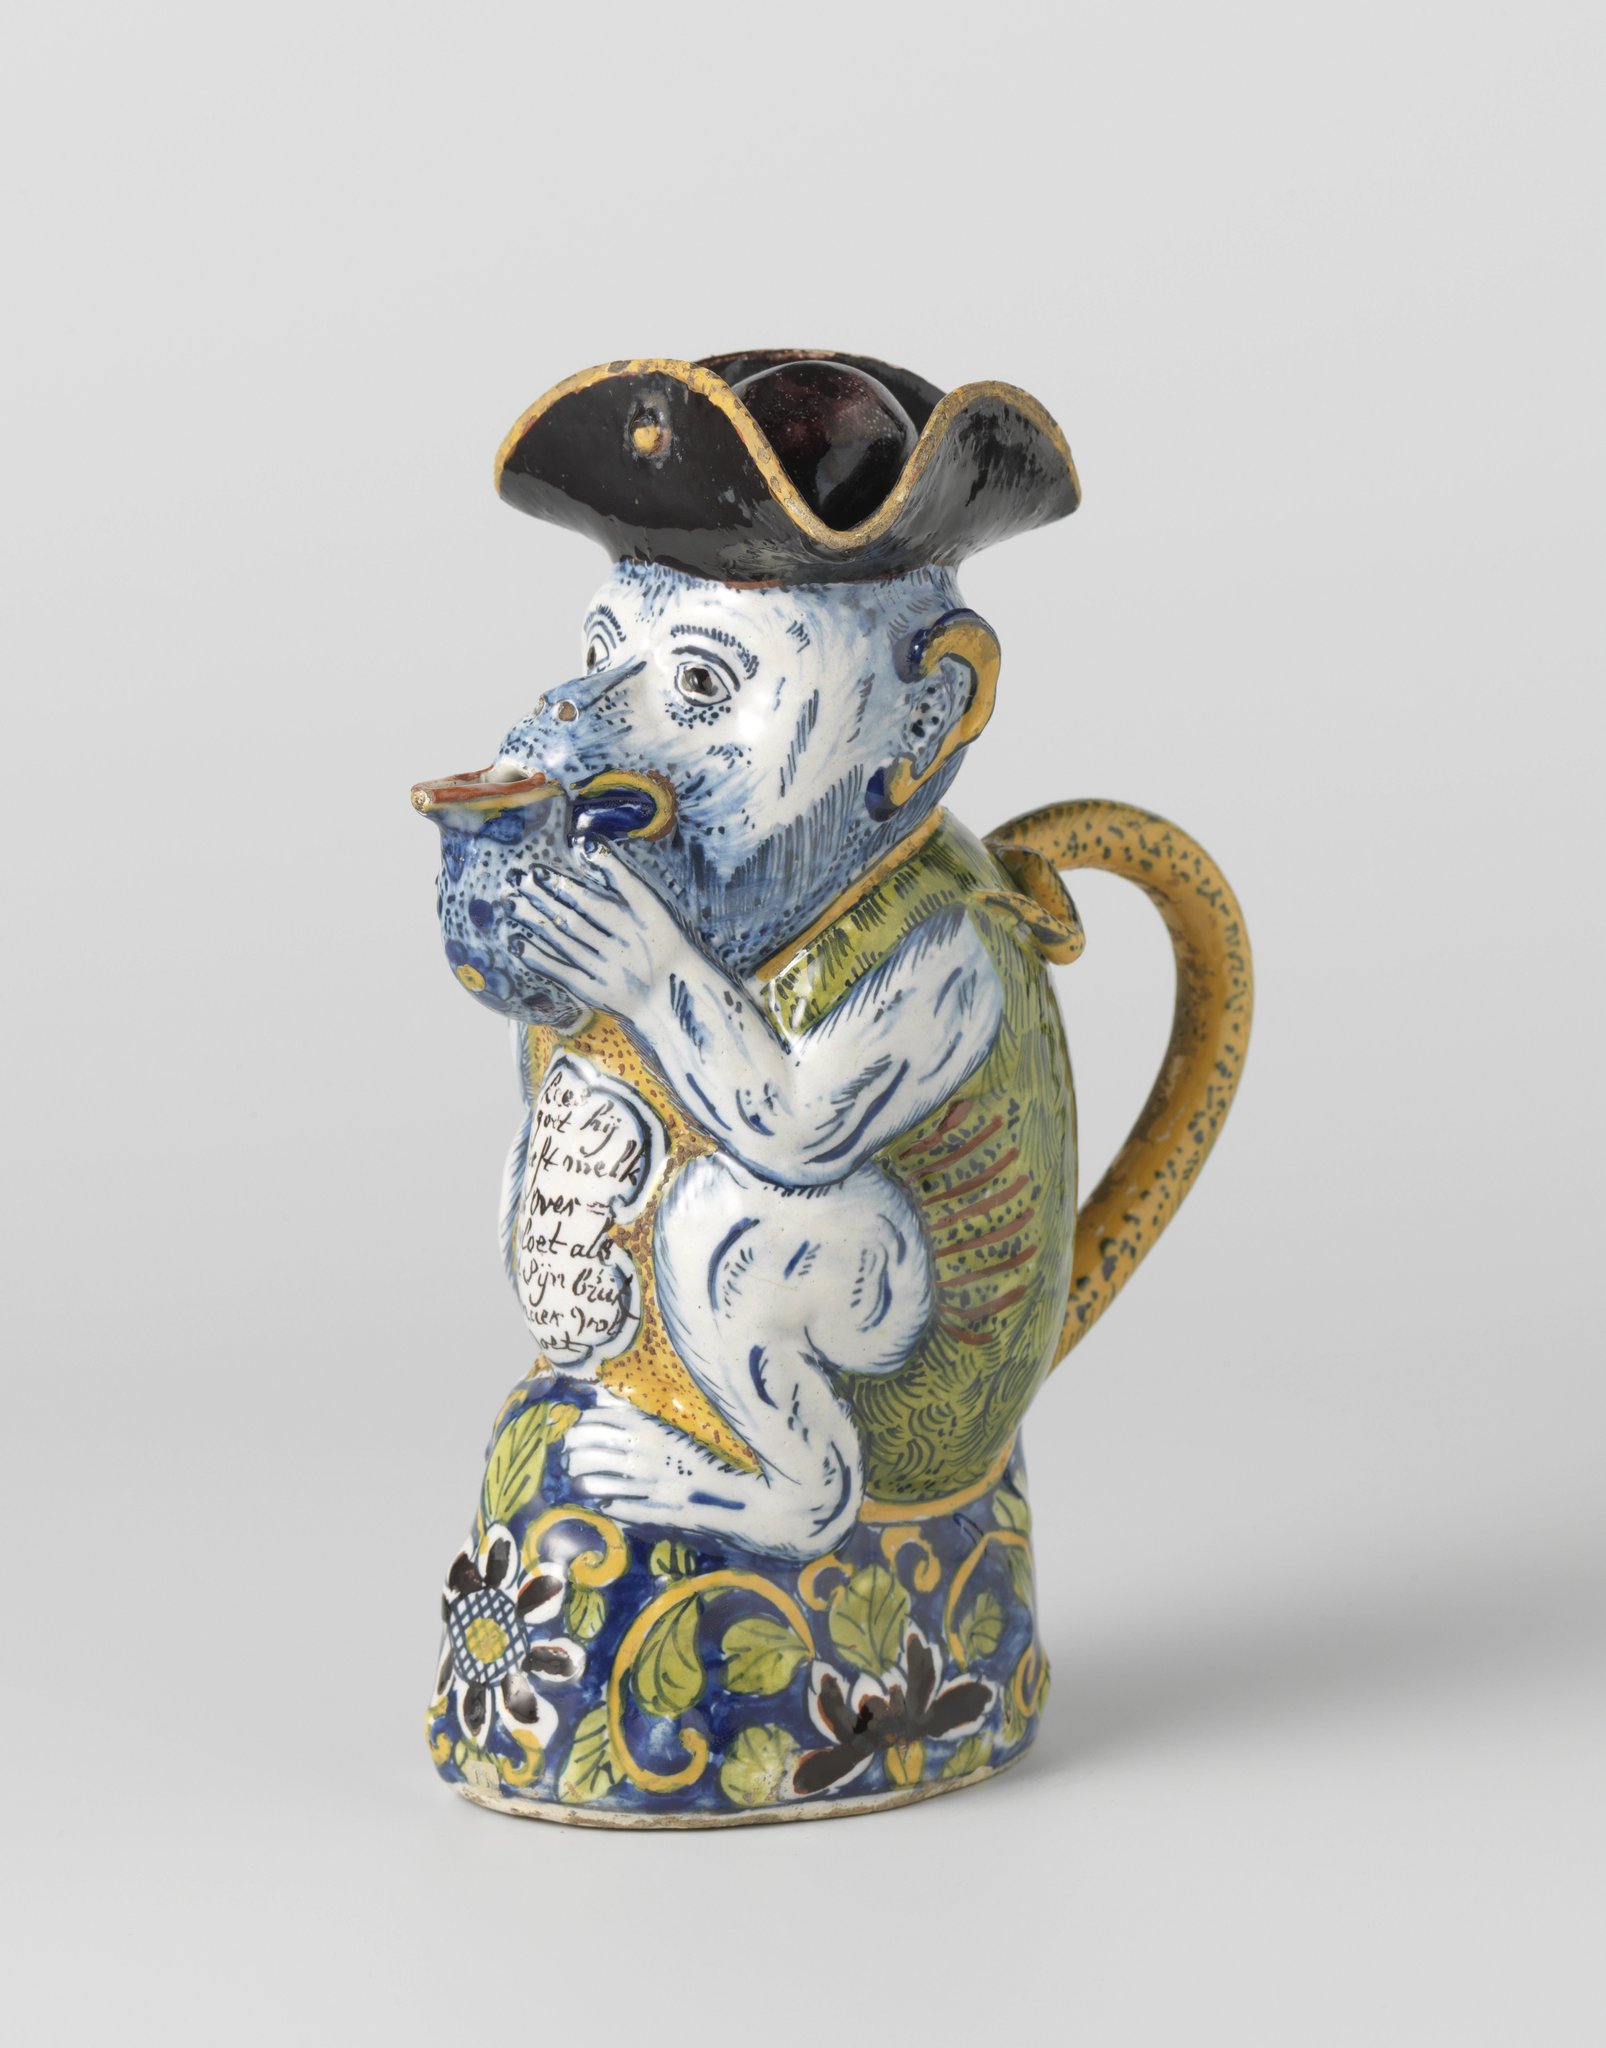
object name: milk jug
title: Milk jug in the form of a monkey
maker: Anonymous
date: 1760-1780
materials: faience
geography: delft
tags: head-gear: tricorn (+ men's clothes), monkeys, apes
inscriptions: inscription: ‘Kees/ is goet/ hij geeft melk/ in over/ vloet als/ je sijn buik/ maar vol doet’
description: Melkkan van faïence, in de vorm van een drinkende aap. Op zijn buik het opschrift: kees is goet hij geeft melk in overvloet als je sijn buik maar vol doet. Met losse deksel.